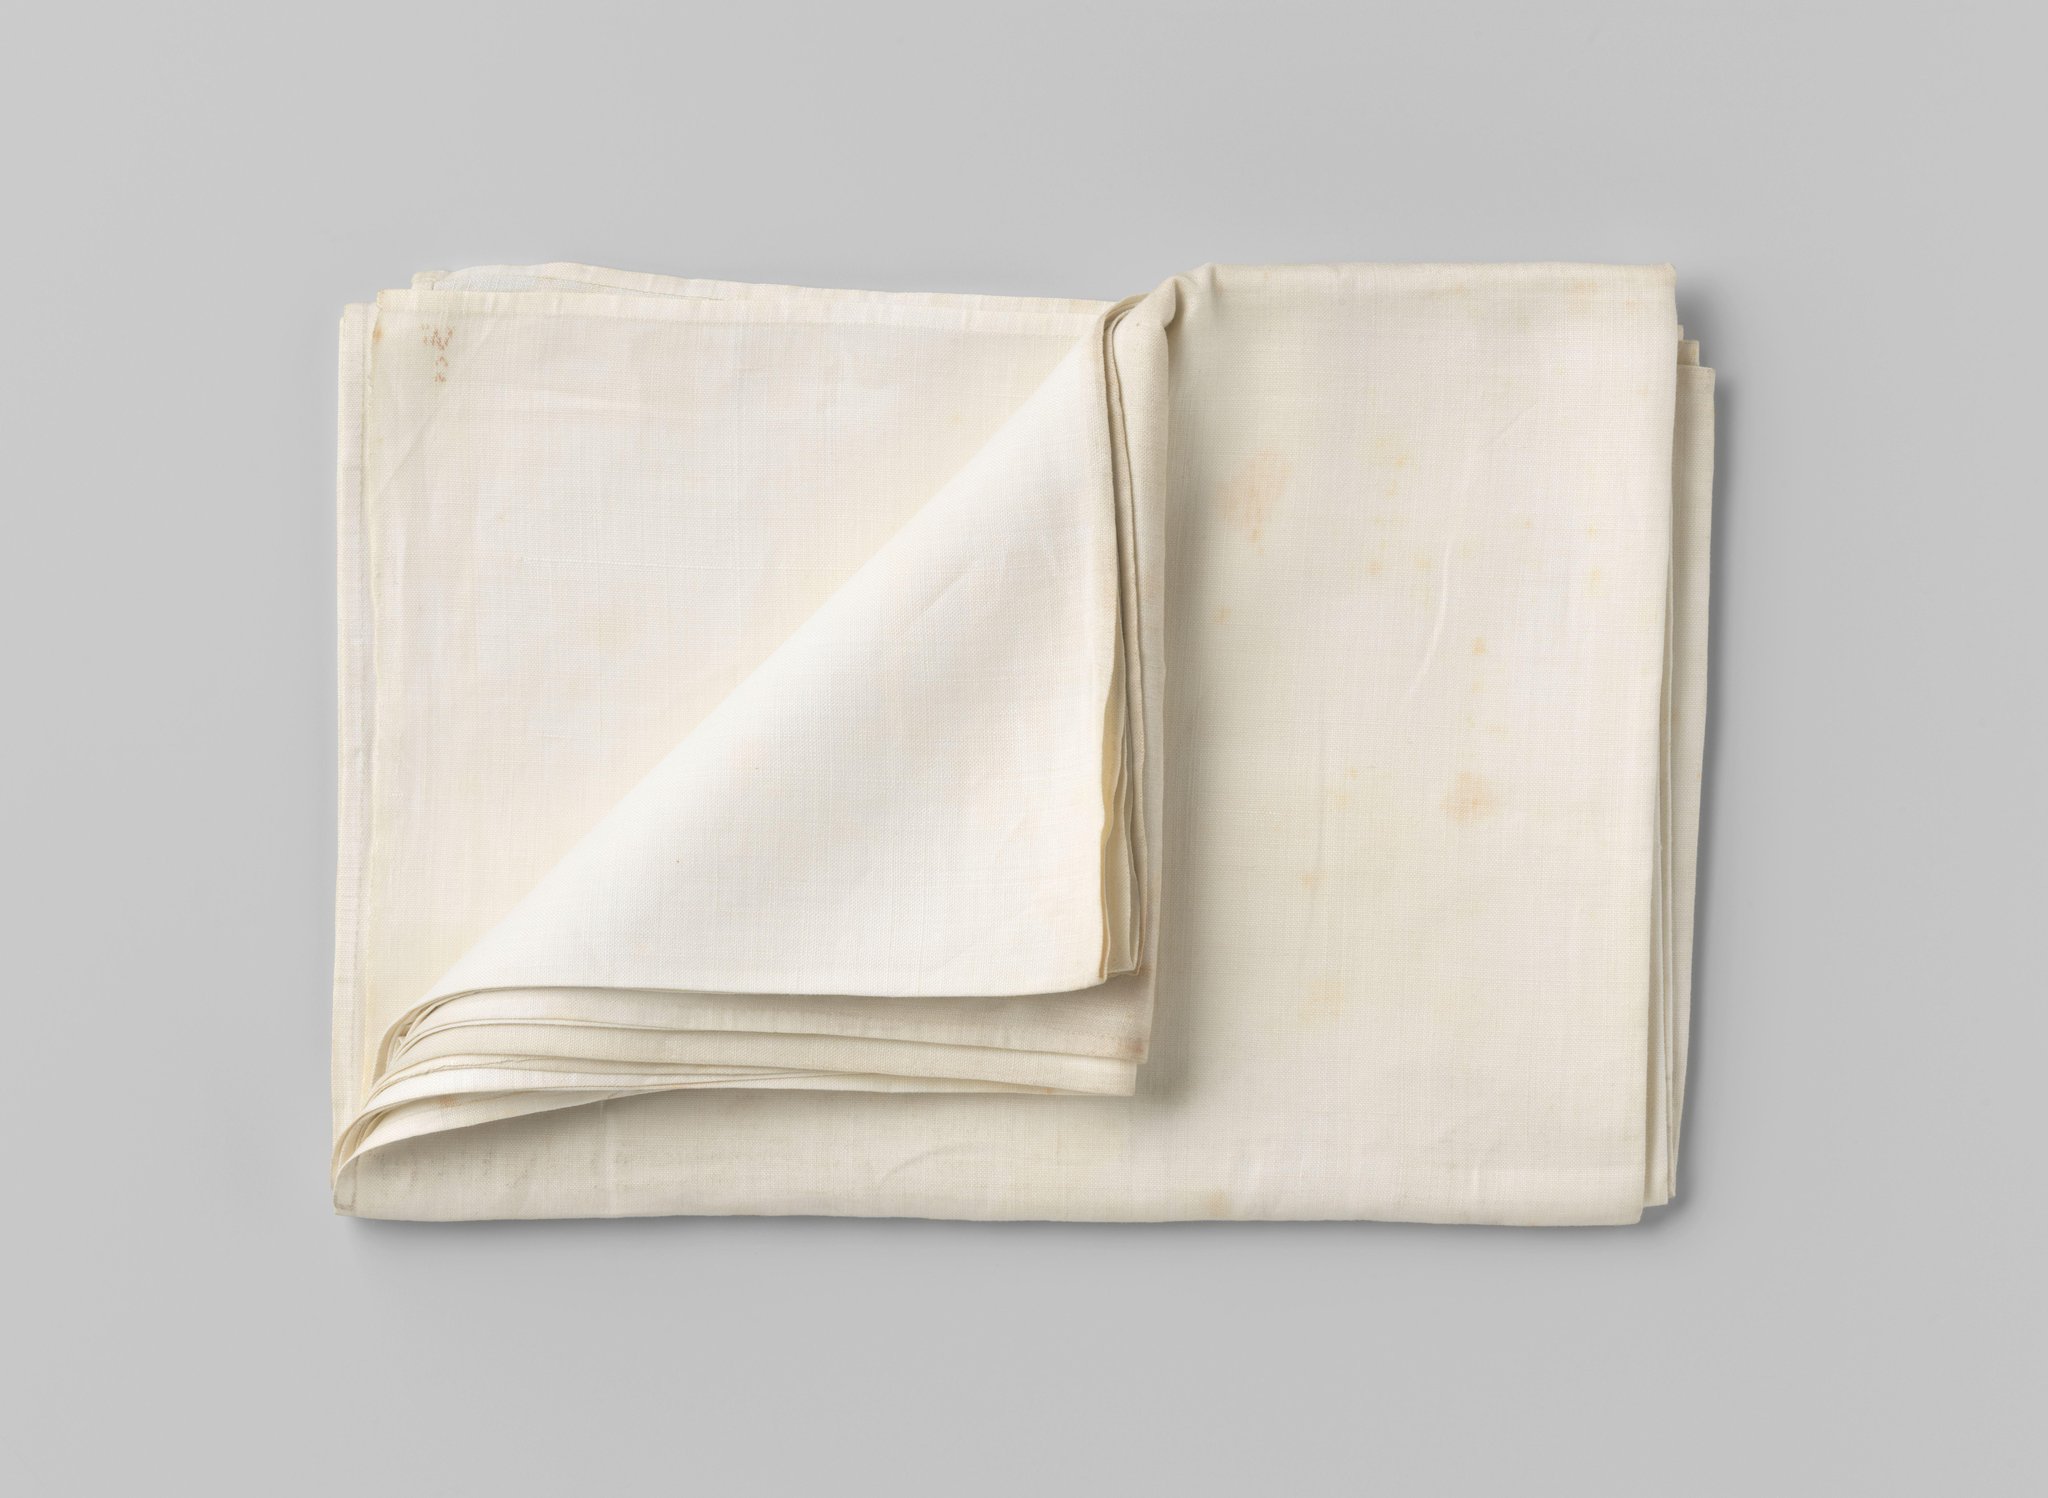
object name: kinderlaken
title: Laken. Merk: W2.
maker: Anonymous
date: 1791-1799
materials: linen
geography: northern netherlands